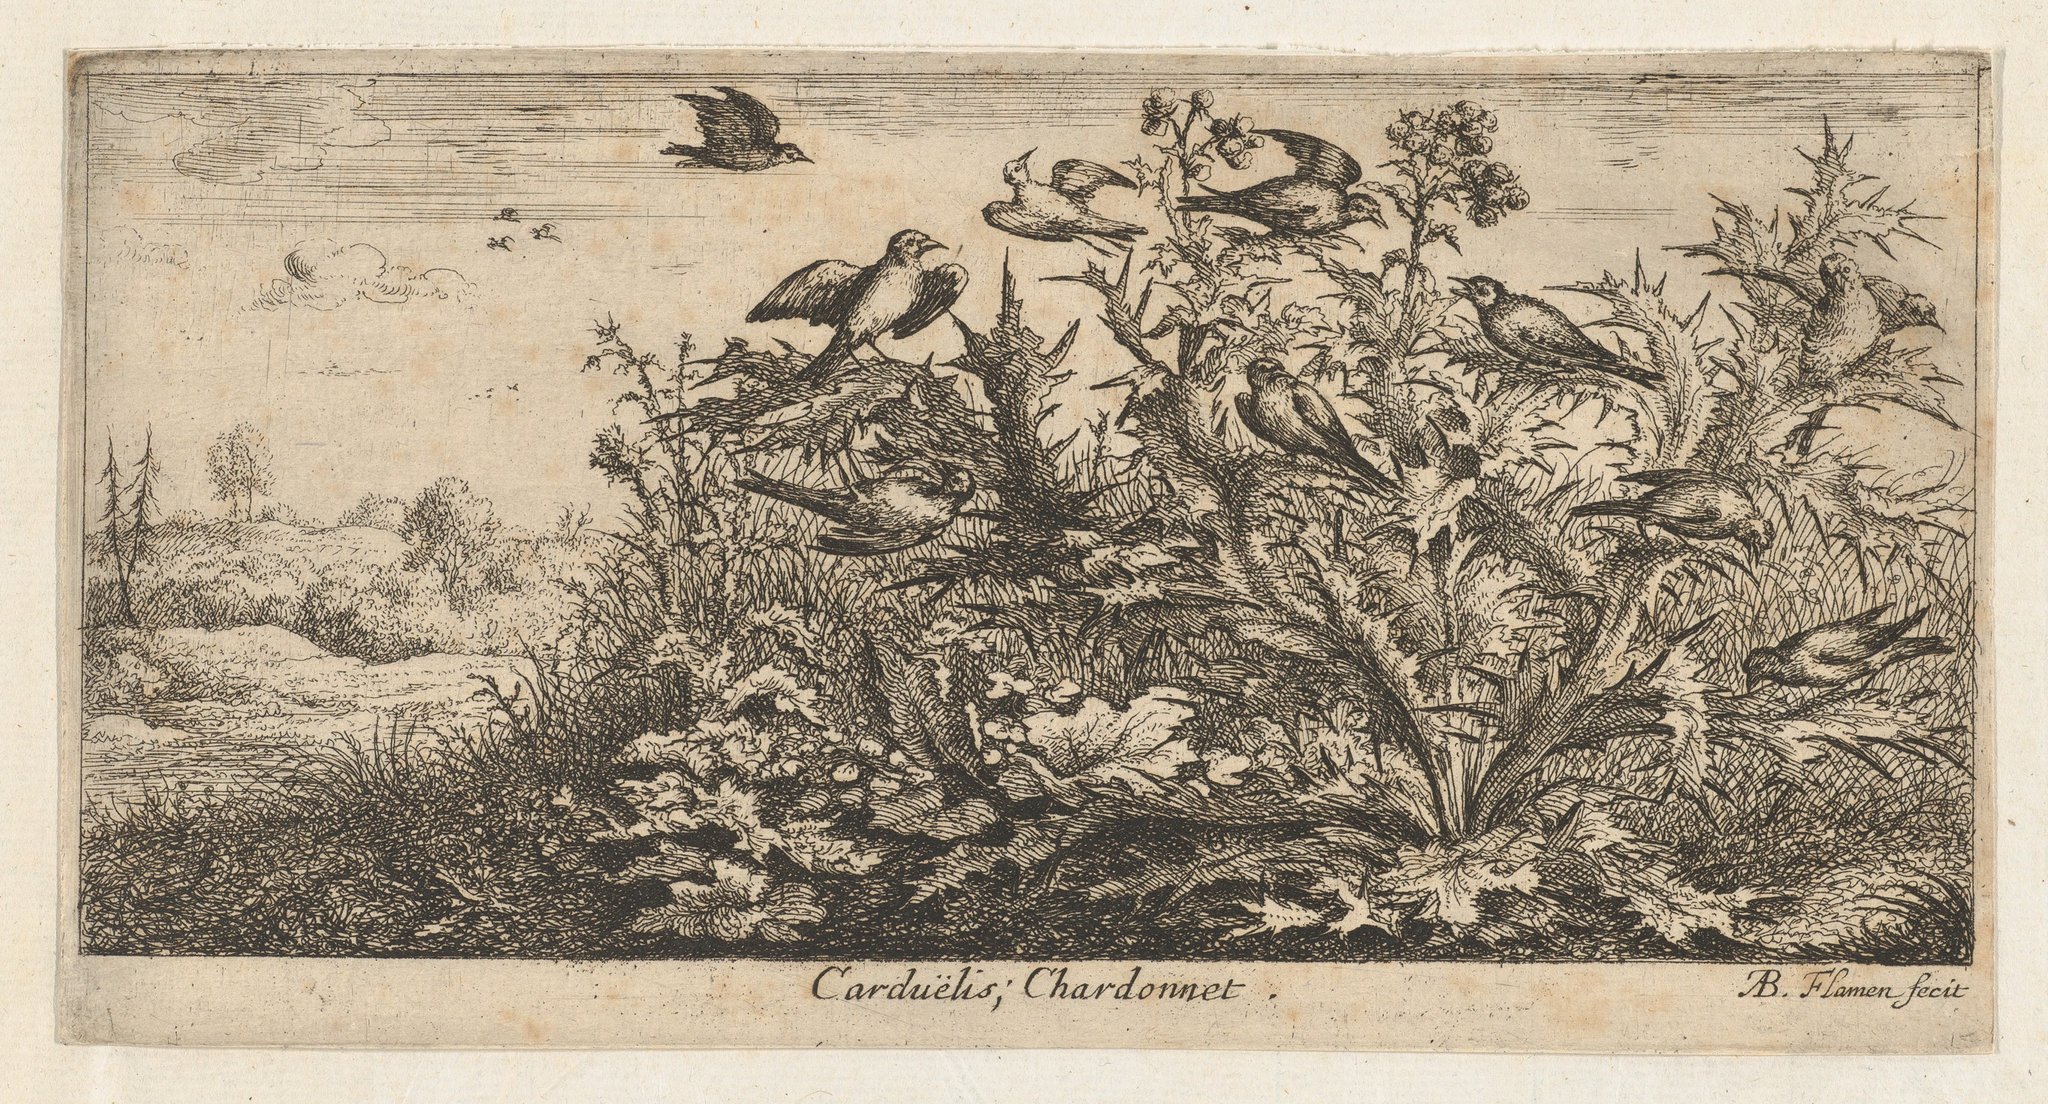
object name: print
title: Carduëlis, Chardonnet (The Goldfinch), from "Livre d'Oyseaux" (Book of Birds)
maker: albert flamen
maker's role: artist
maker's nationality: flemish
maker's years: 1615-1688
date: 1655-1660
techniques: etching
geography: france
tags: birds,plants